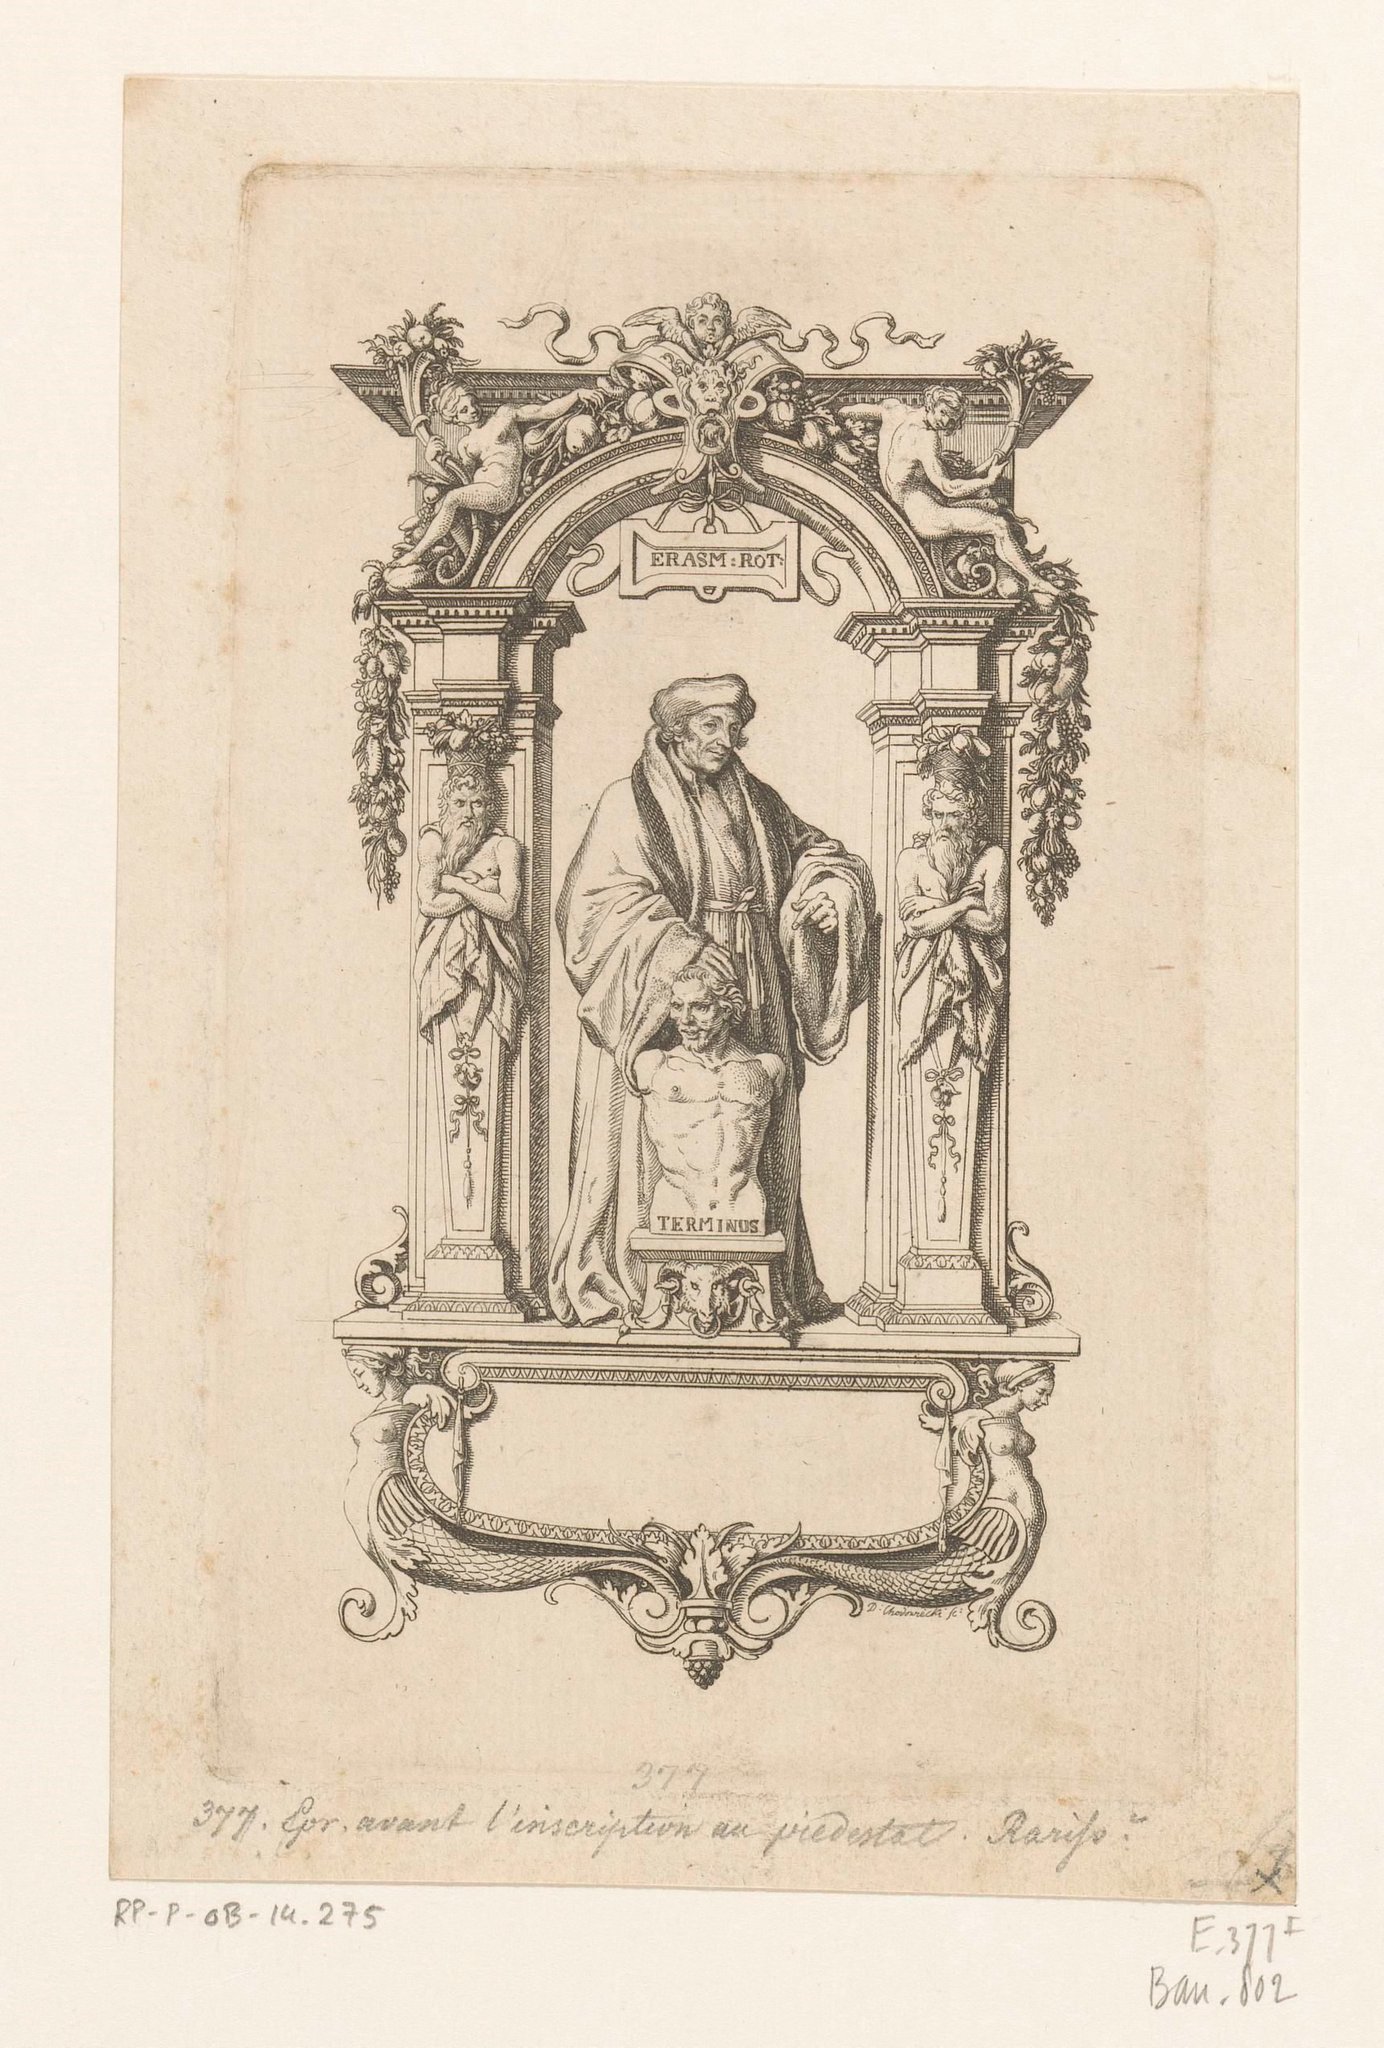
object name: print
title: Beeld van Erasmus in architecturale omlijsting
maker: daniel nikolaus chodowiecki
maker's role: draughtsman, print maker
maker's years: 1726-1801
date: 1780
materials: paper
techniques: etching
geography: gdansk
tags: desiderius erasmus, cherubs, i.e. children's heads with wings, 'cornucopia', horn of plenty, herms (garden ornaments), merman - aa - mermaid, siren, terminus, ornament ~ cartouche, sculpture, ornament ~ festoon, garland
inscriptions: collector's mark: Lugt 2228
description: Prent gebruikt voor: Erasmus, Desiderius. Das Lob der Narrheit aus dem Lateinischen des Erasmus. Mit Kupfern von Chodowiecky. Berlijn en Leipzig: Georg Jacob Decker, 1781.